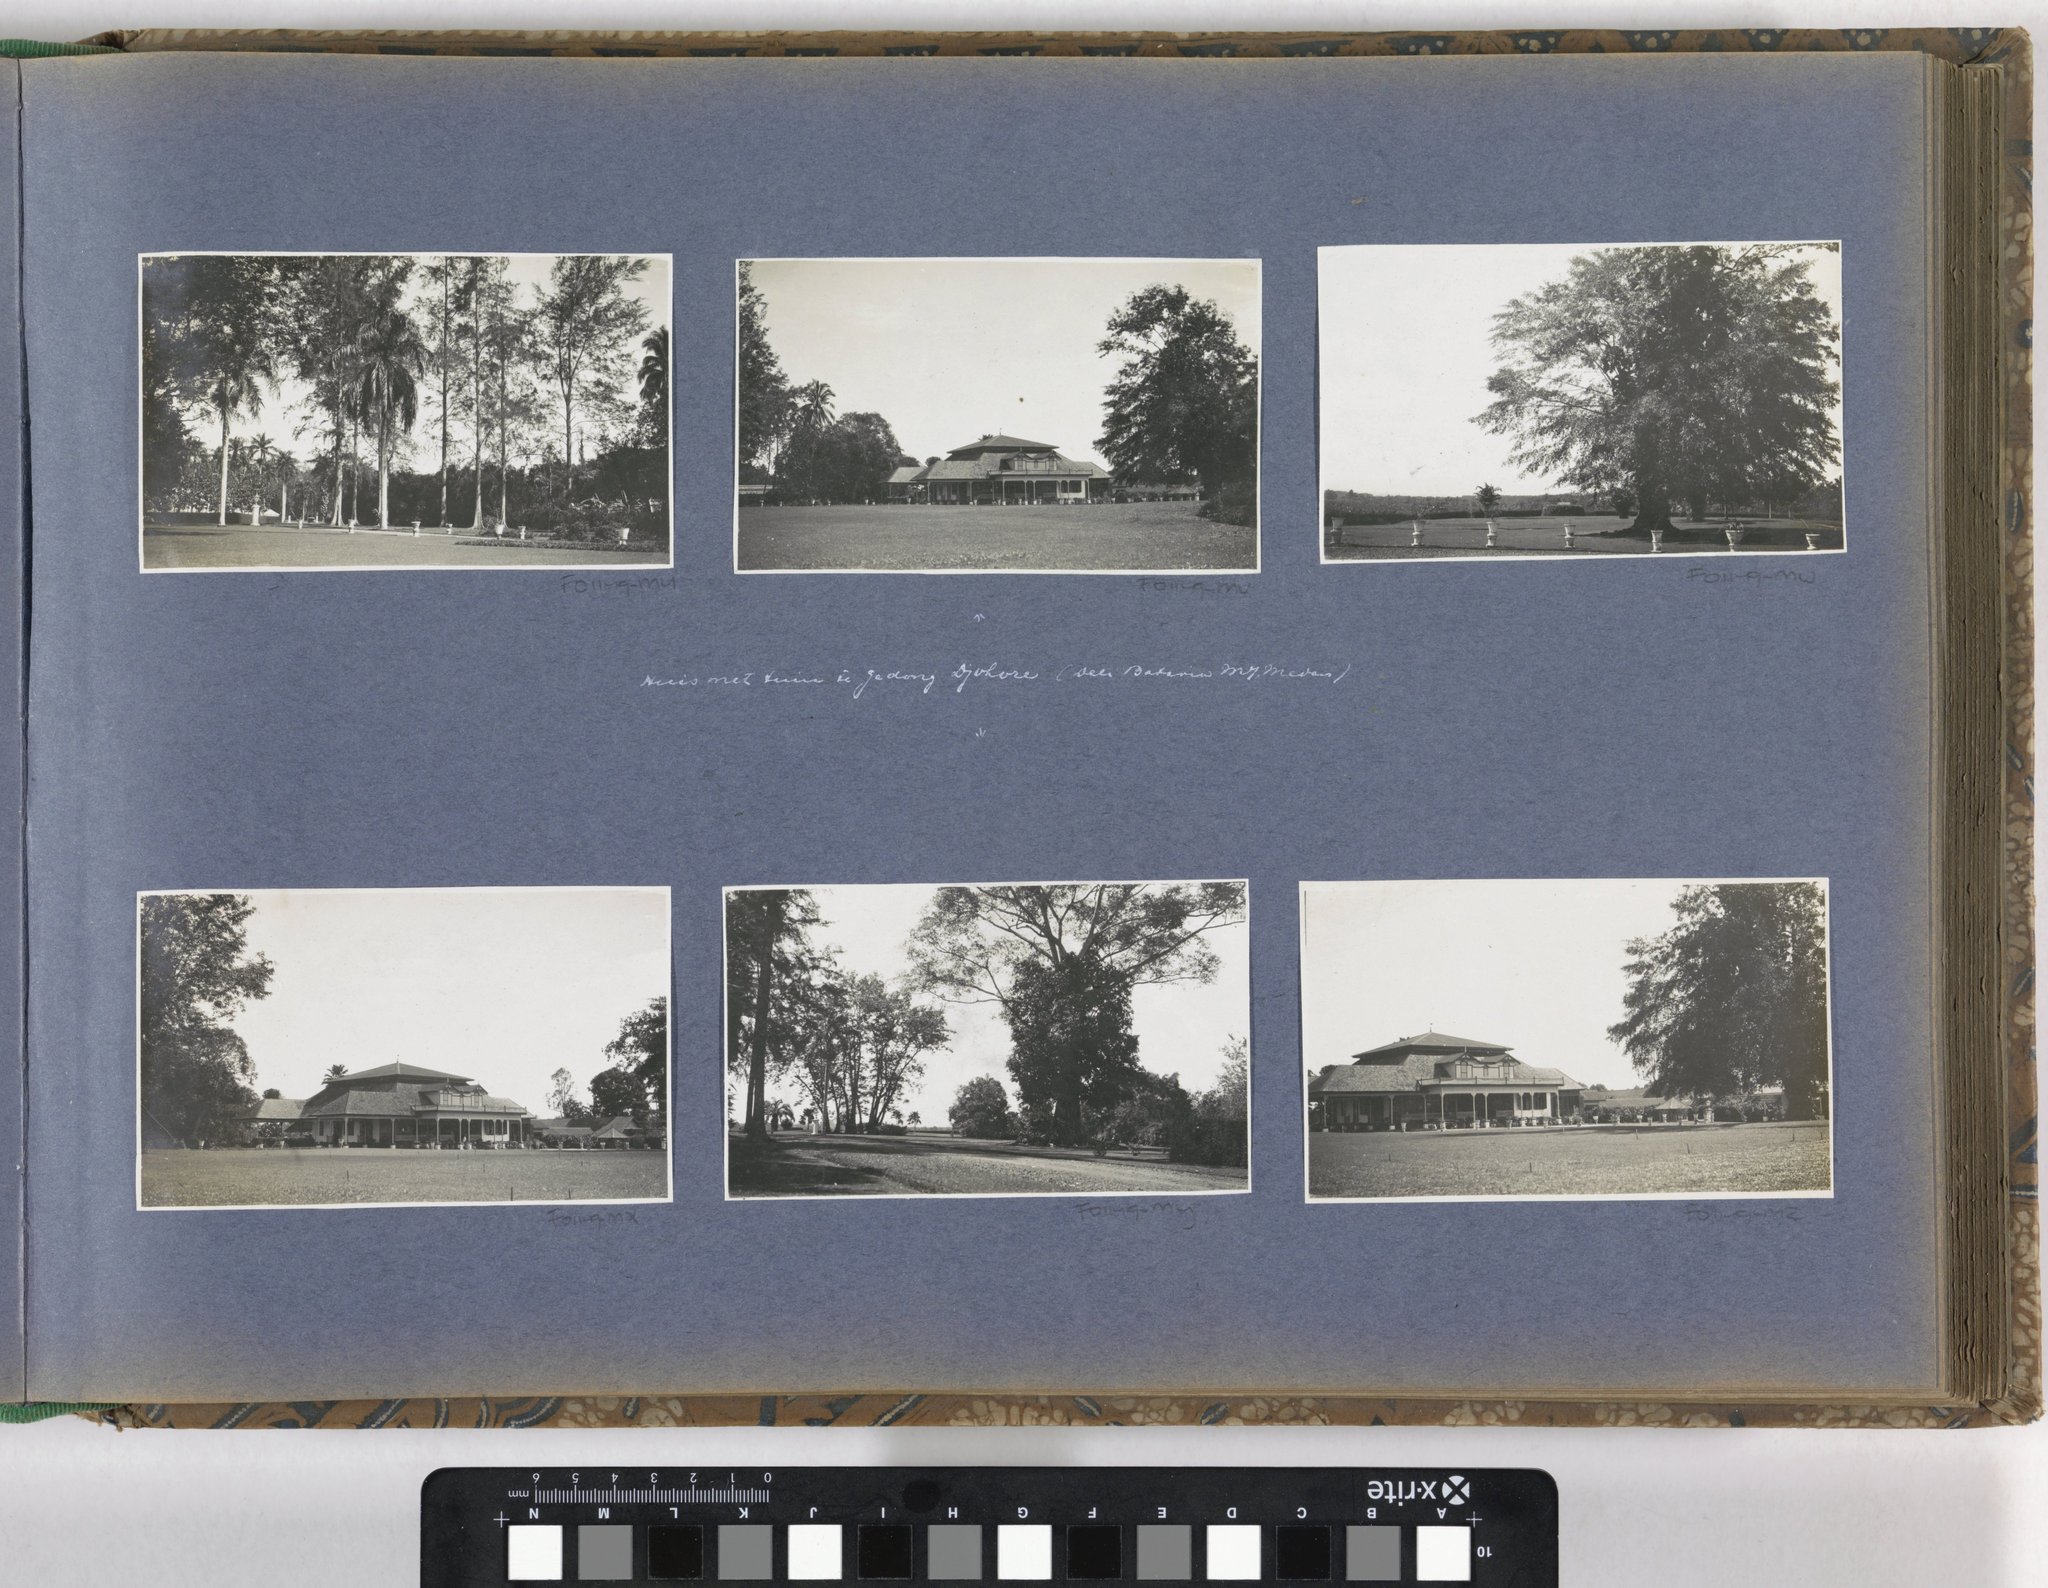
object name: photograph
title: Tuin van cultuuronderneming Gedong Djohore van de Deli-Batavia Maatschappij bij Medan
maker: Anonymous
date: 1900-1920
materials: paper, photographic support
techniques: gelatin silver print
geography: sumatra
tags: plantation, trees, garden, sumatra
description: Onderdeel van reisalbum met foto's van bedrijvigheid en bezienswaardigheden op Sumatra en Java en van de reis naar en van Nederlands-Indië.